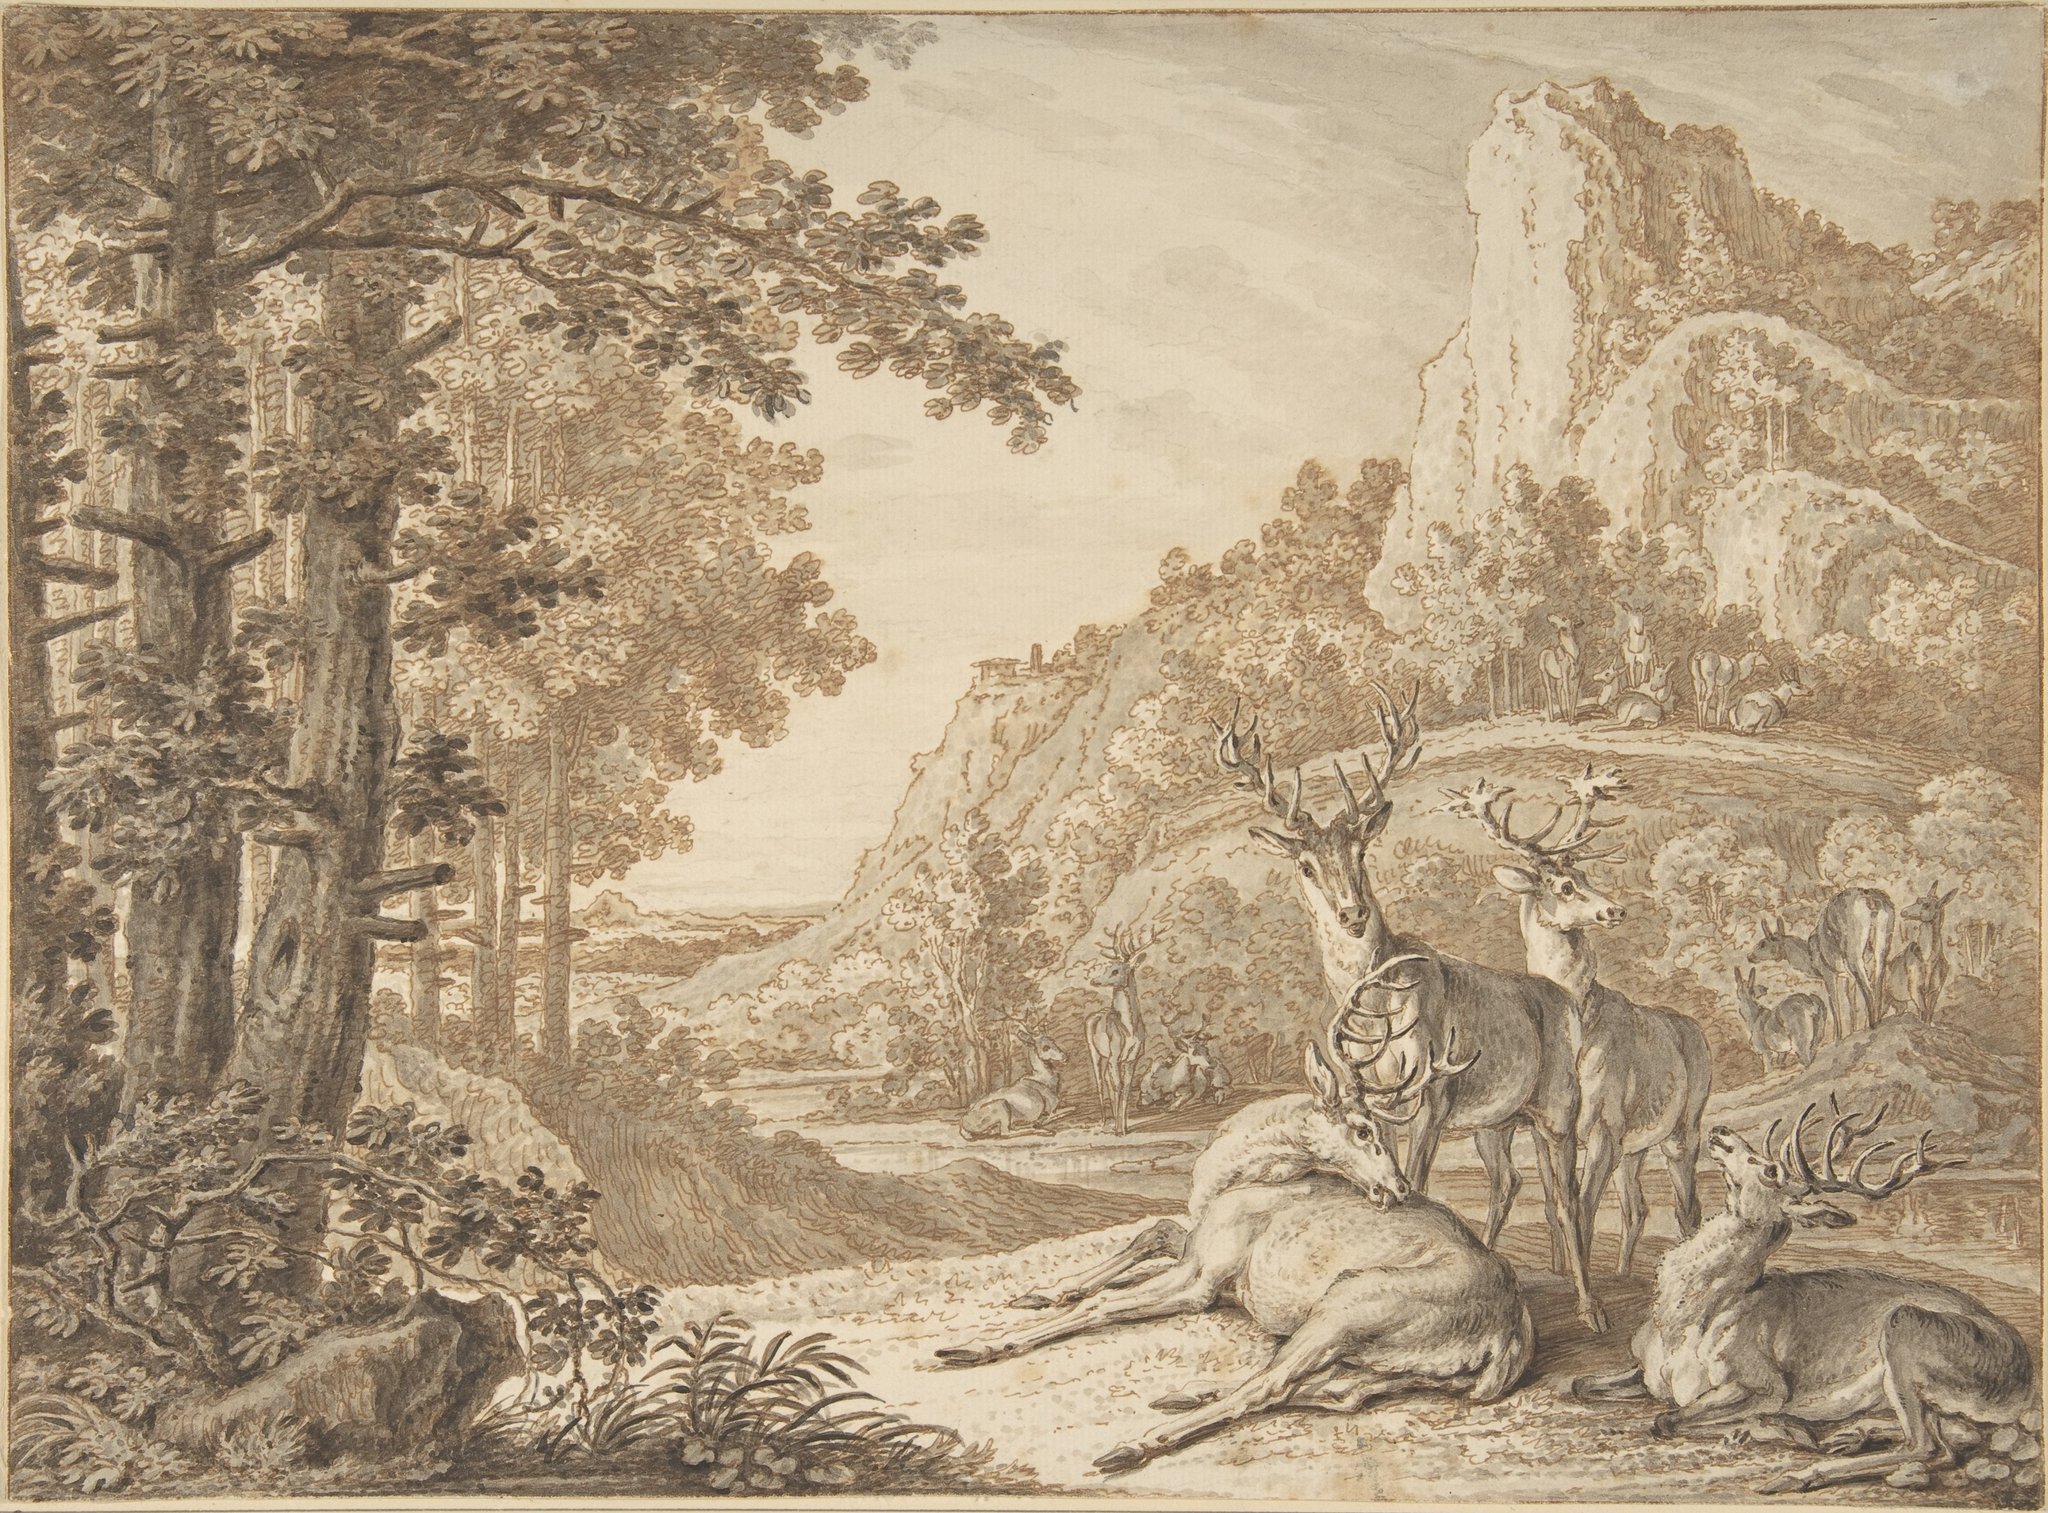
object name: drawing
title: Stags in a Landscape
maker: johann elias ridinger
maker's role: artist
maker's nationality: german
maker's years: 1698-1767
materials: ink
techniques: brush, pen, wash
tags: deer,landscapes,trees